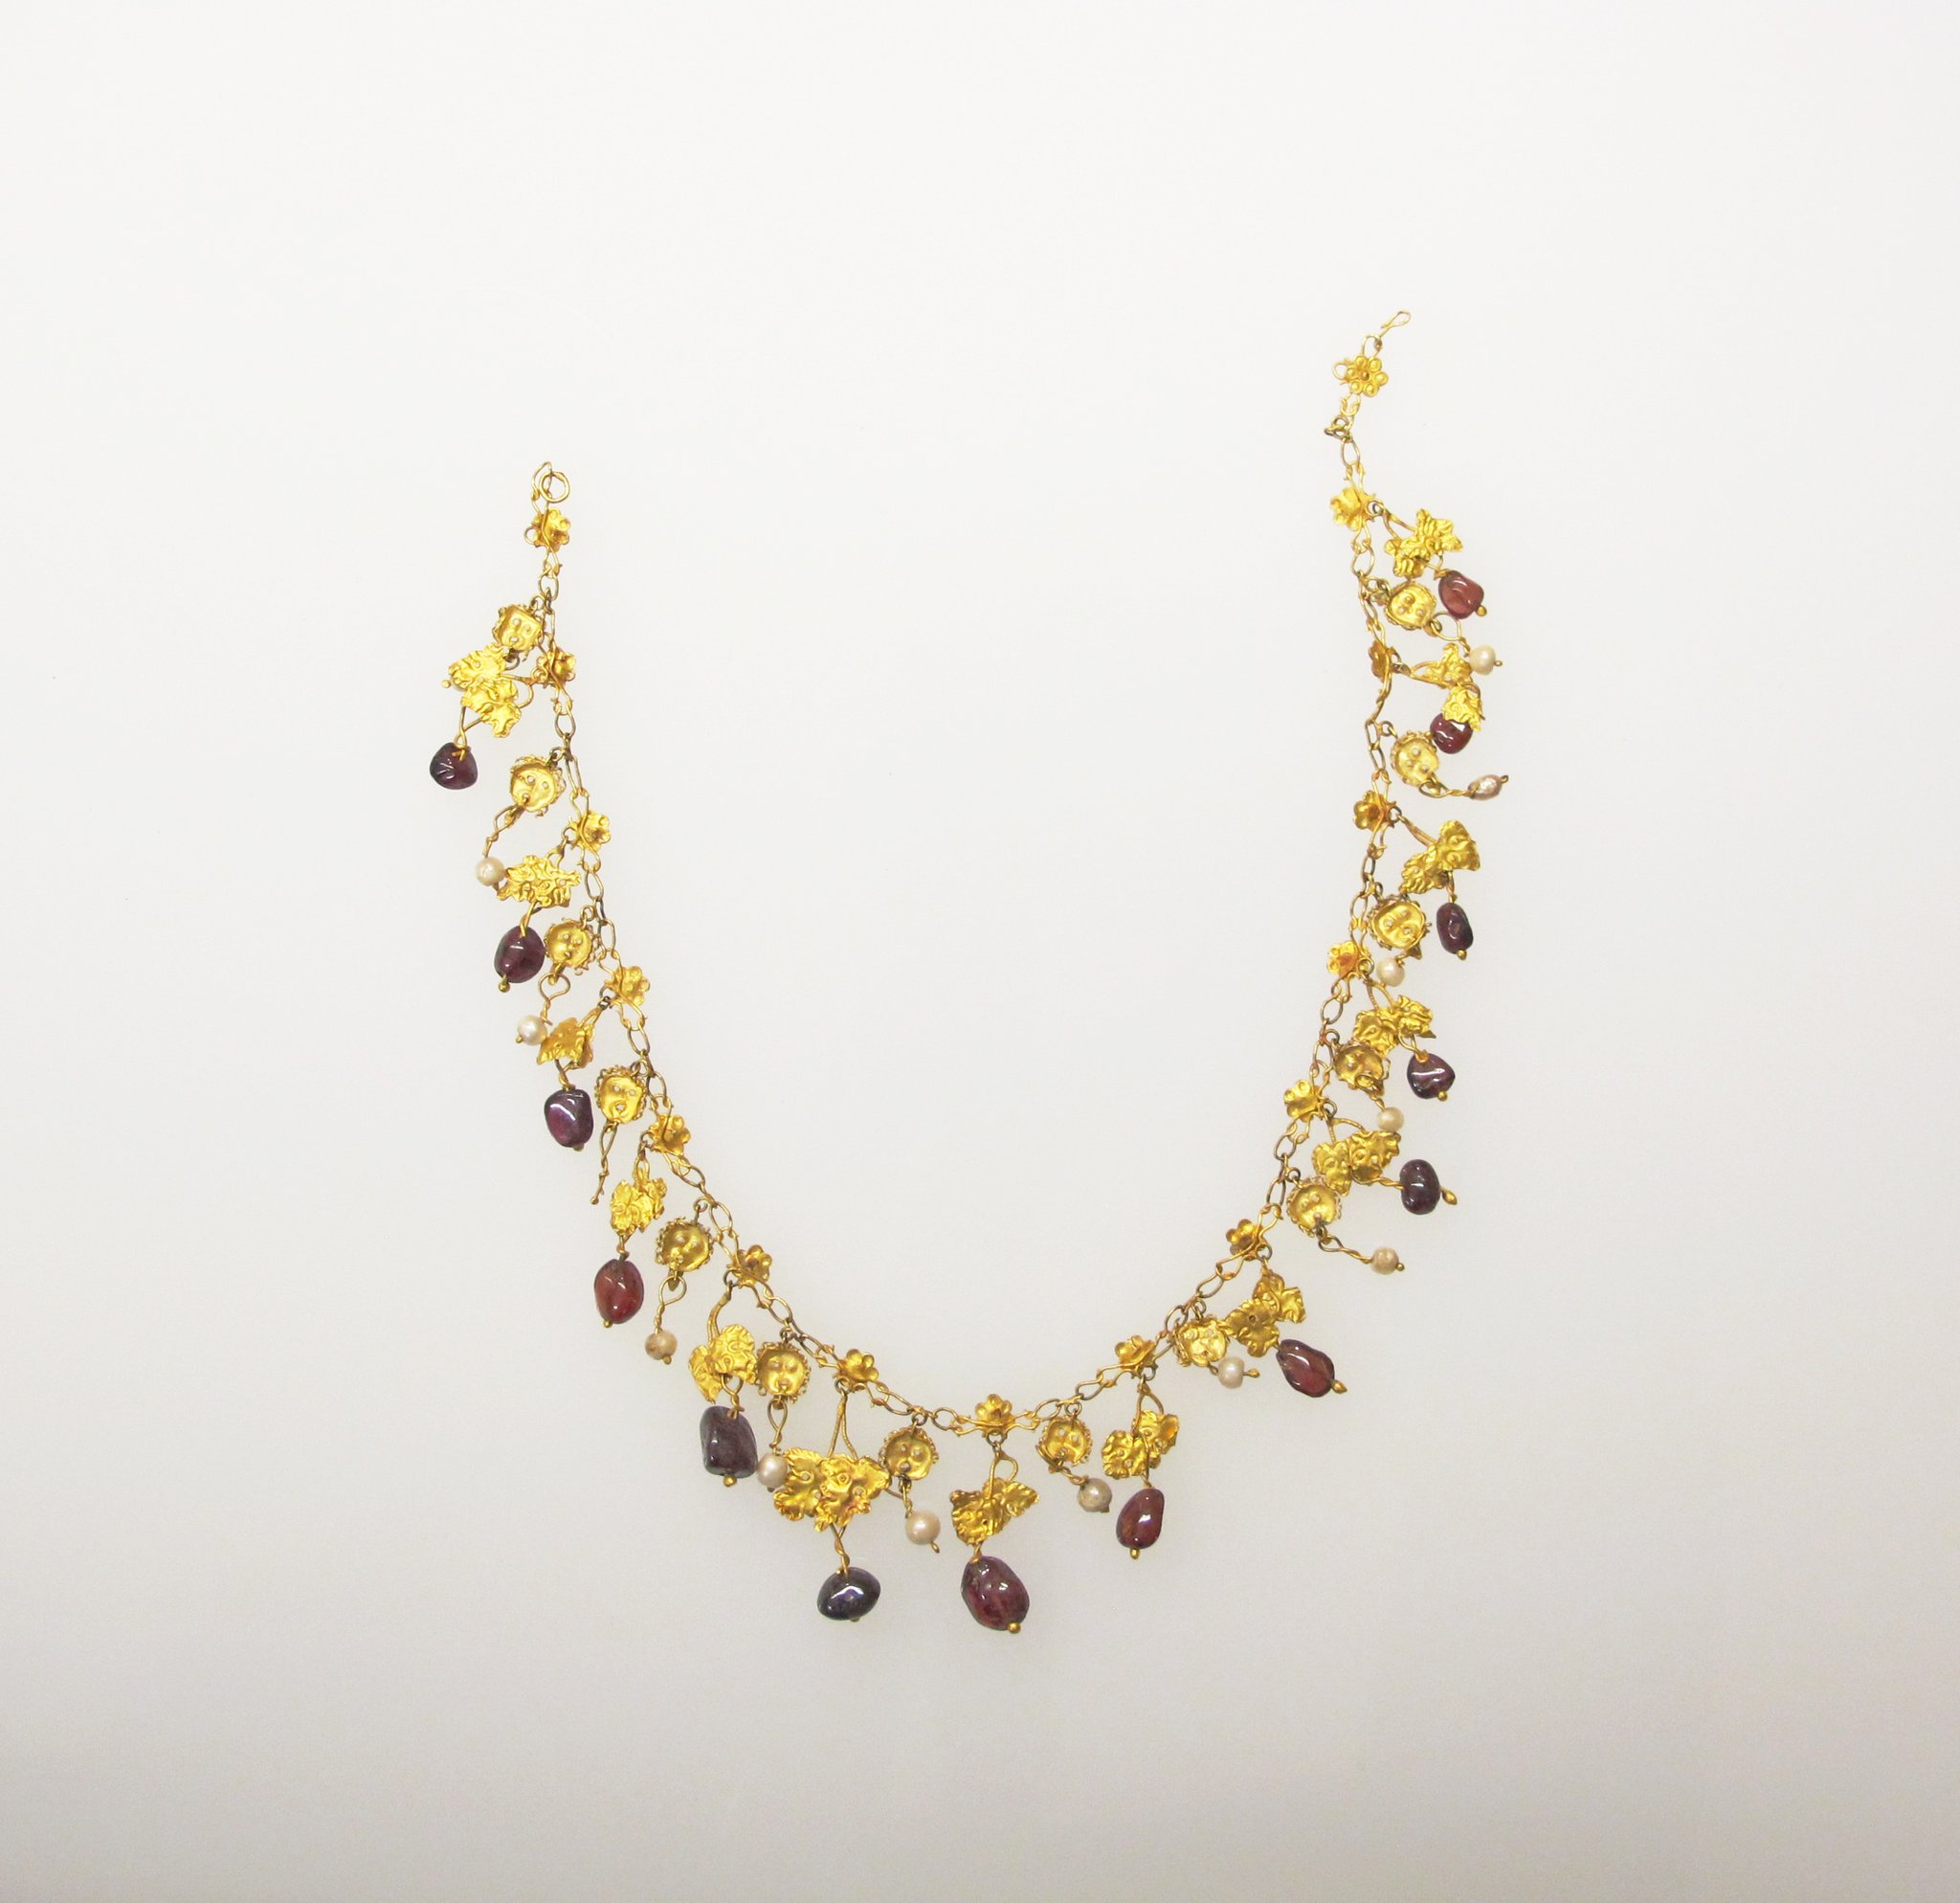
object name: necklace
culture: roman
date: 1-200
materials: gemstone, gold, pearl